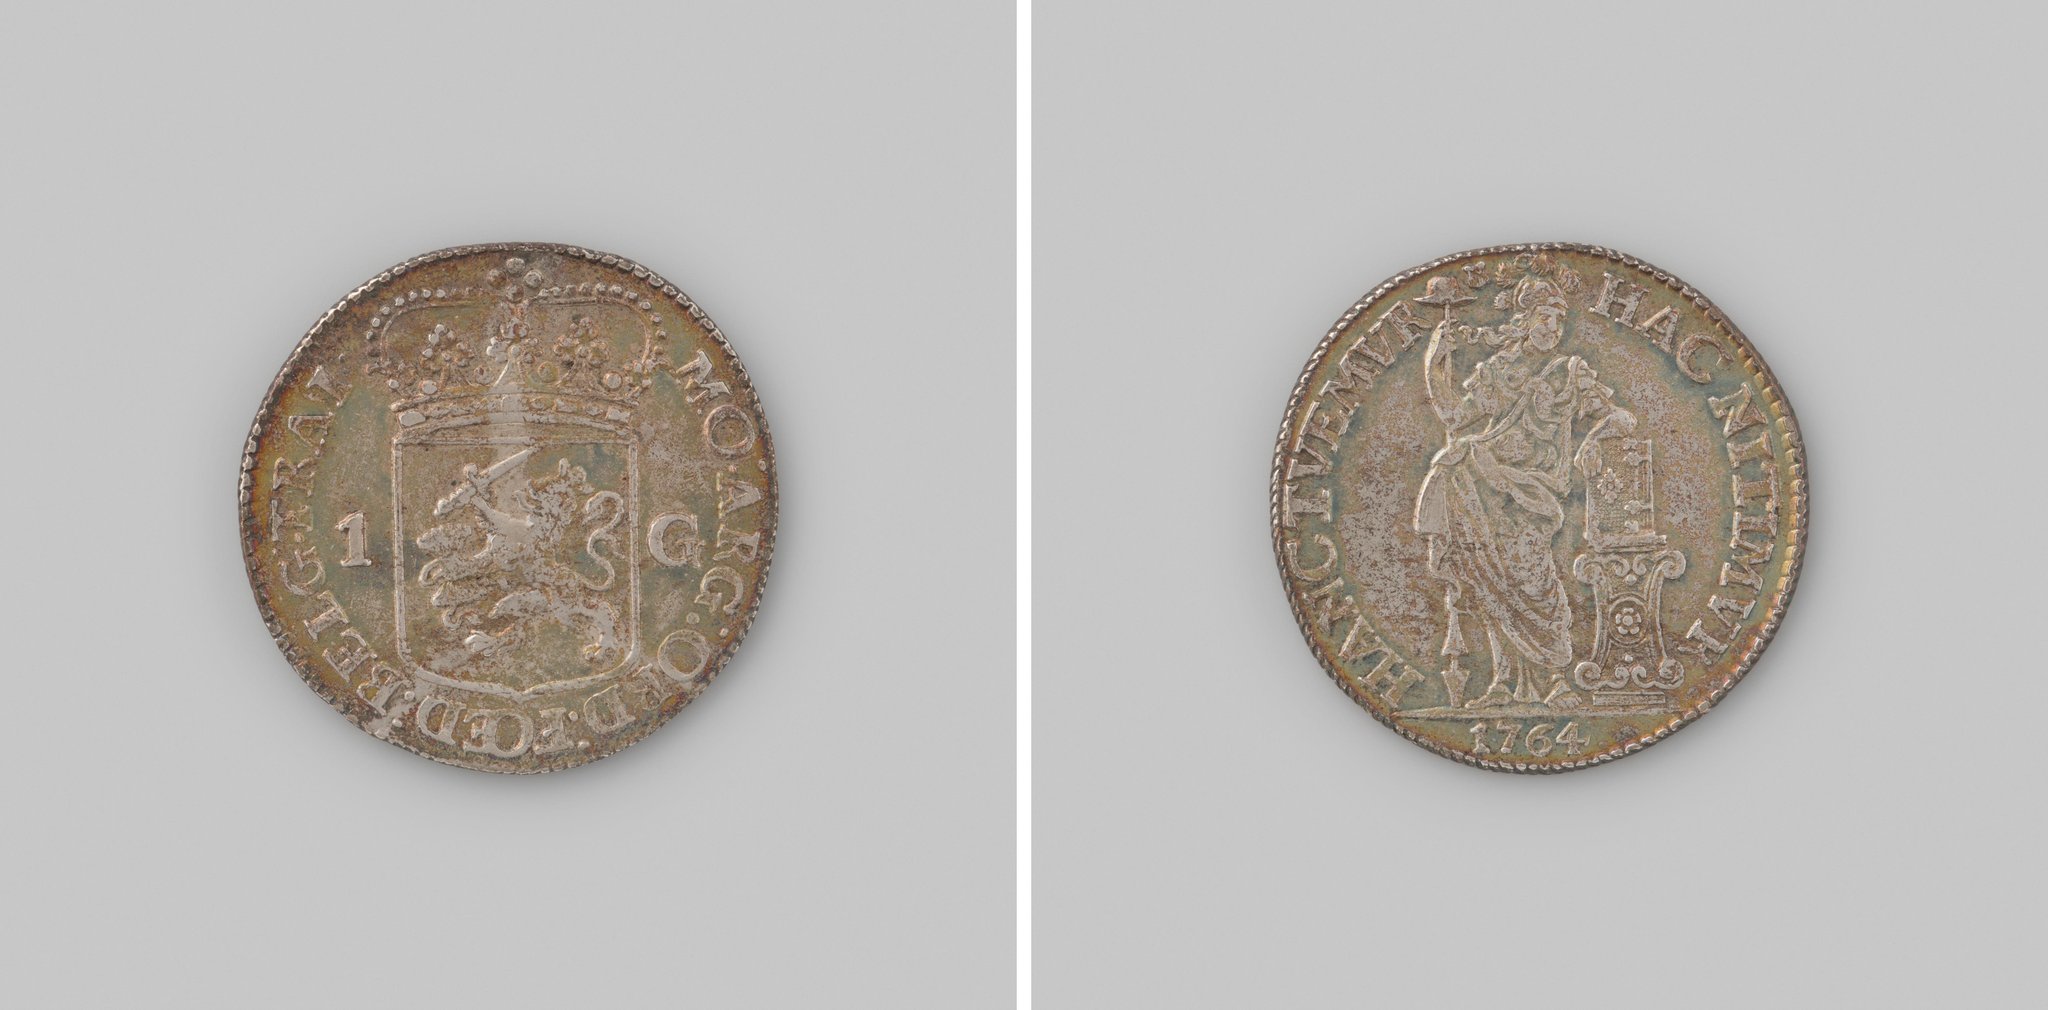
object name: coin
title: Utrecht, gulden, 1764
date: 1764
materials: silver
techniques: striking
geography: utrecht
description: Voorzijde: tussen waarde-aanduiding gekroond generaliteirtswapenschild. Keerzijde: Nederlandse maagd met vrijheidshoed en speer, leunend op een bijbel op een altaar. In afsnede jaartal.